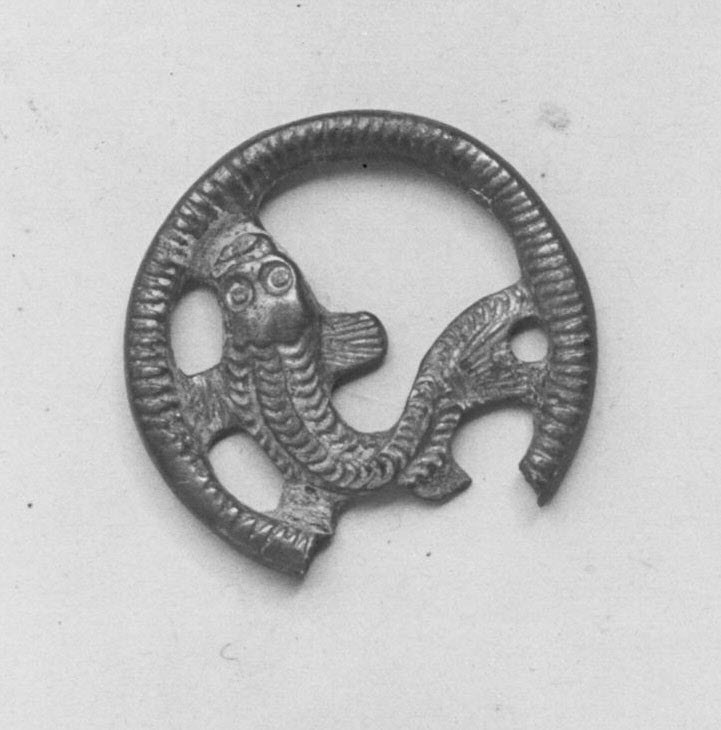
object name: ornament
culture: korean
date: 918-1392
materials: silver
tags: fish